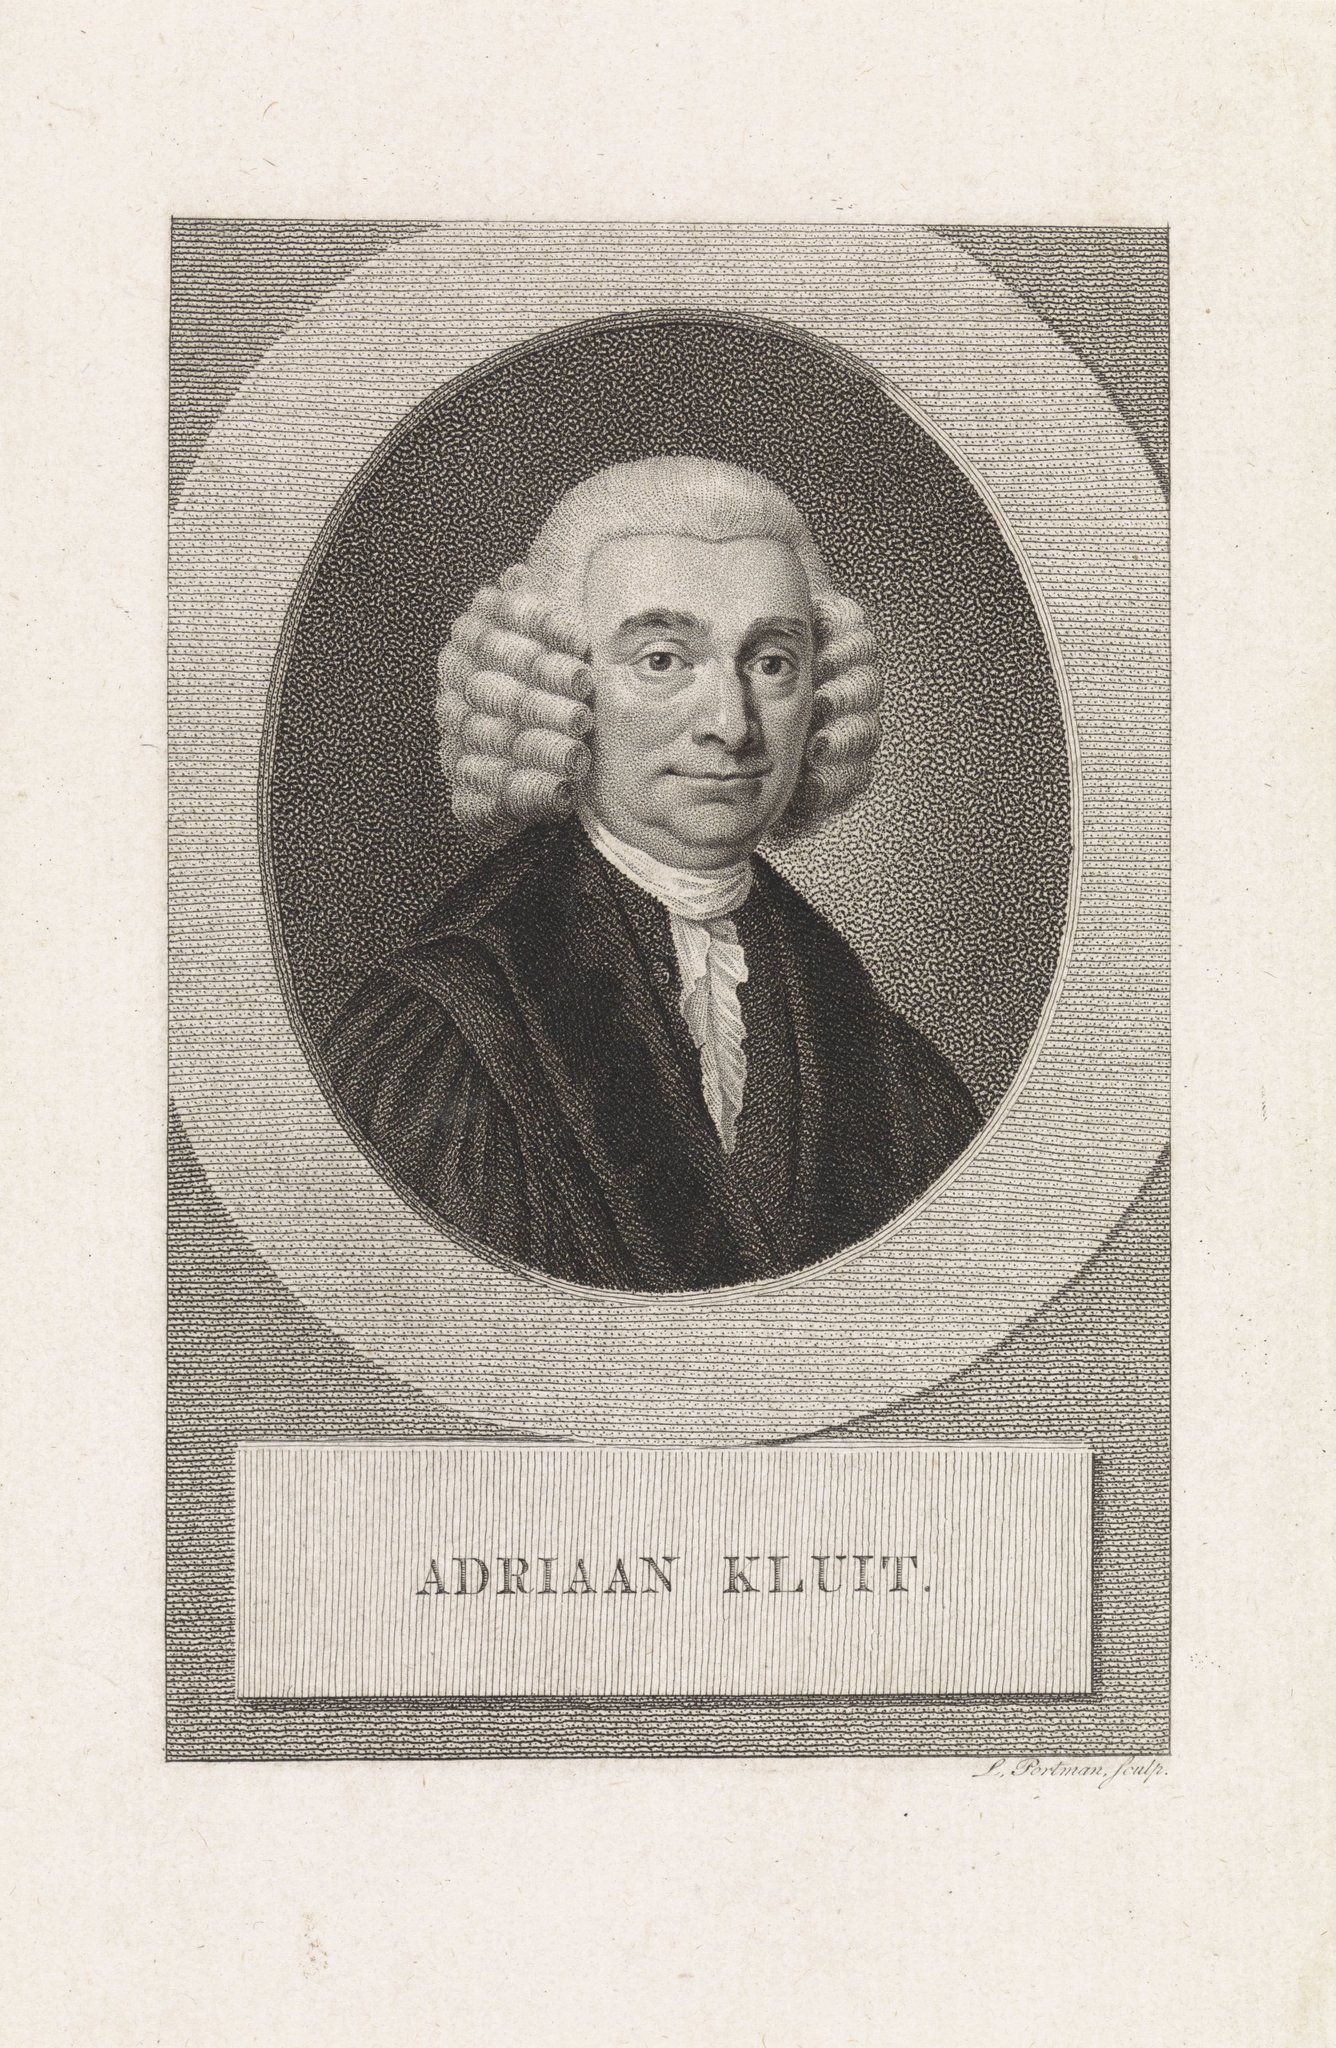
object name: print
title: Portret van professor Adriaan Kluit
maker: ludwig gottlieb portman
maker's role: print maker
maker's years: 1772-1828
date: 1787-1828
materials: paper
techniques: stippled etching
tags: dordrecht, leiden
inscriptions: collector's mark: Lugt 2228